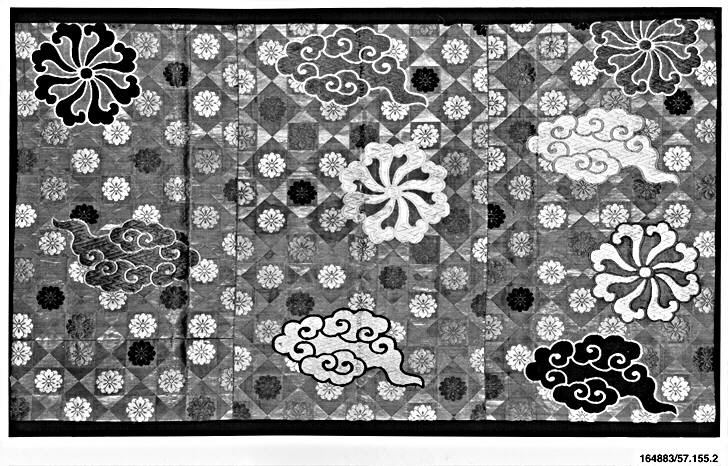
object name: length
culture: japanese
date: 1601-1700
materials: metal thread, silk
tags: flowers